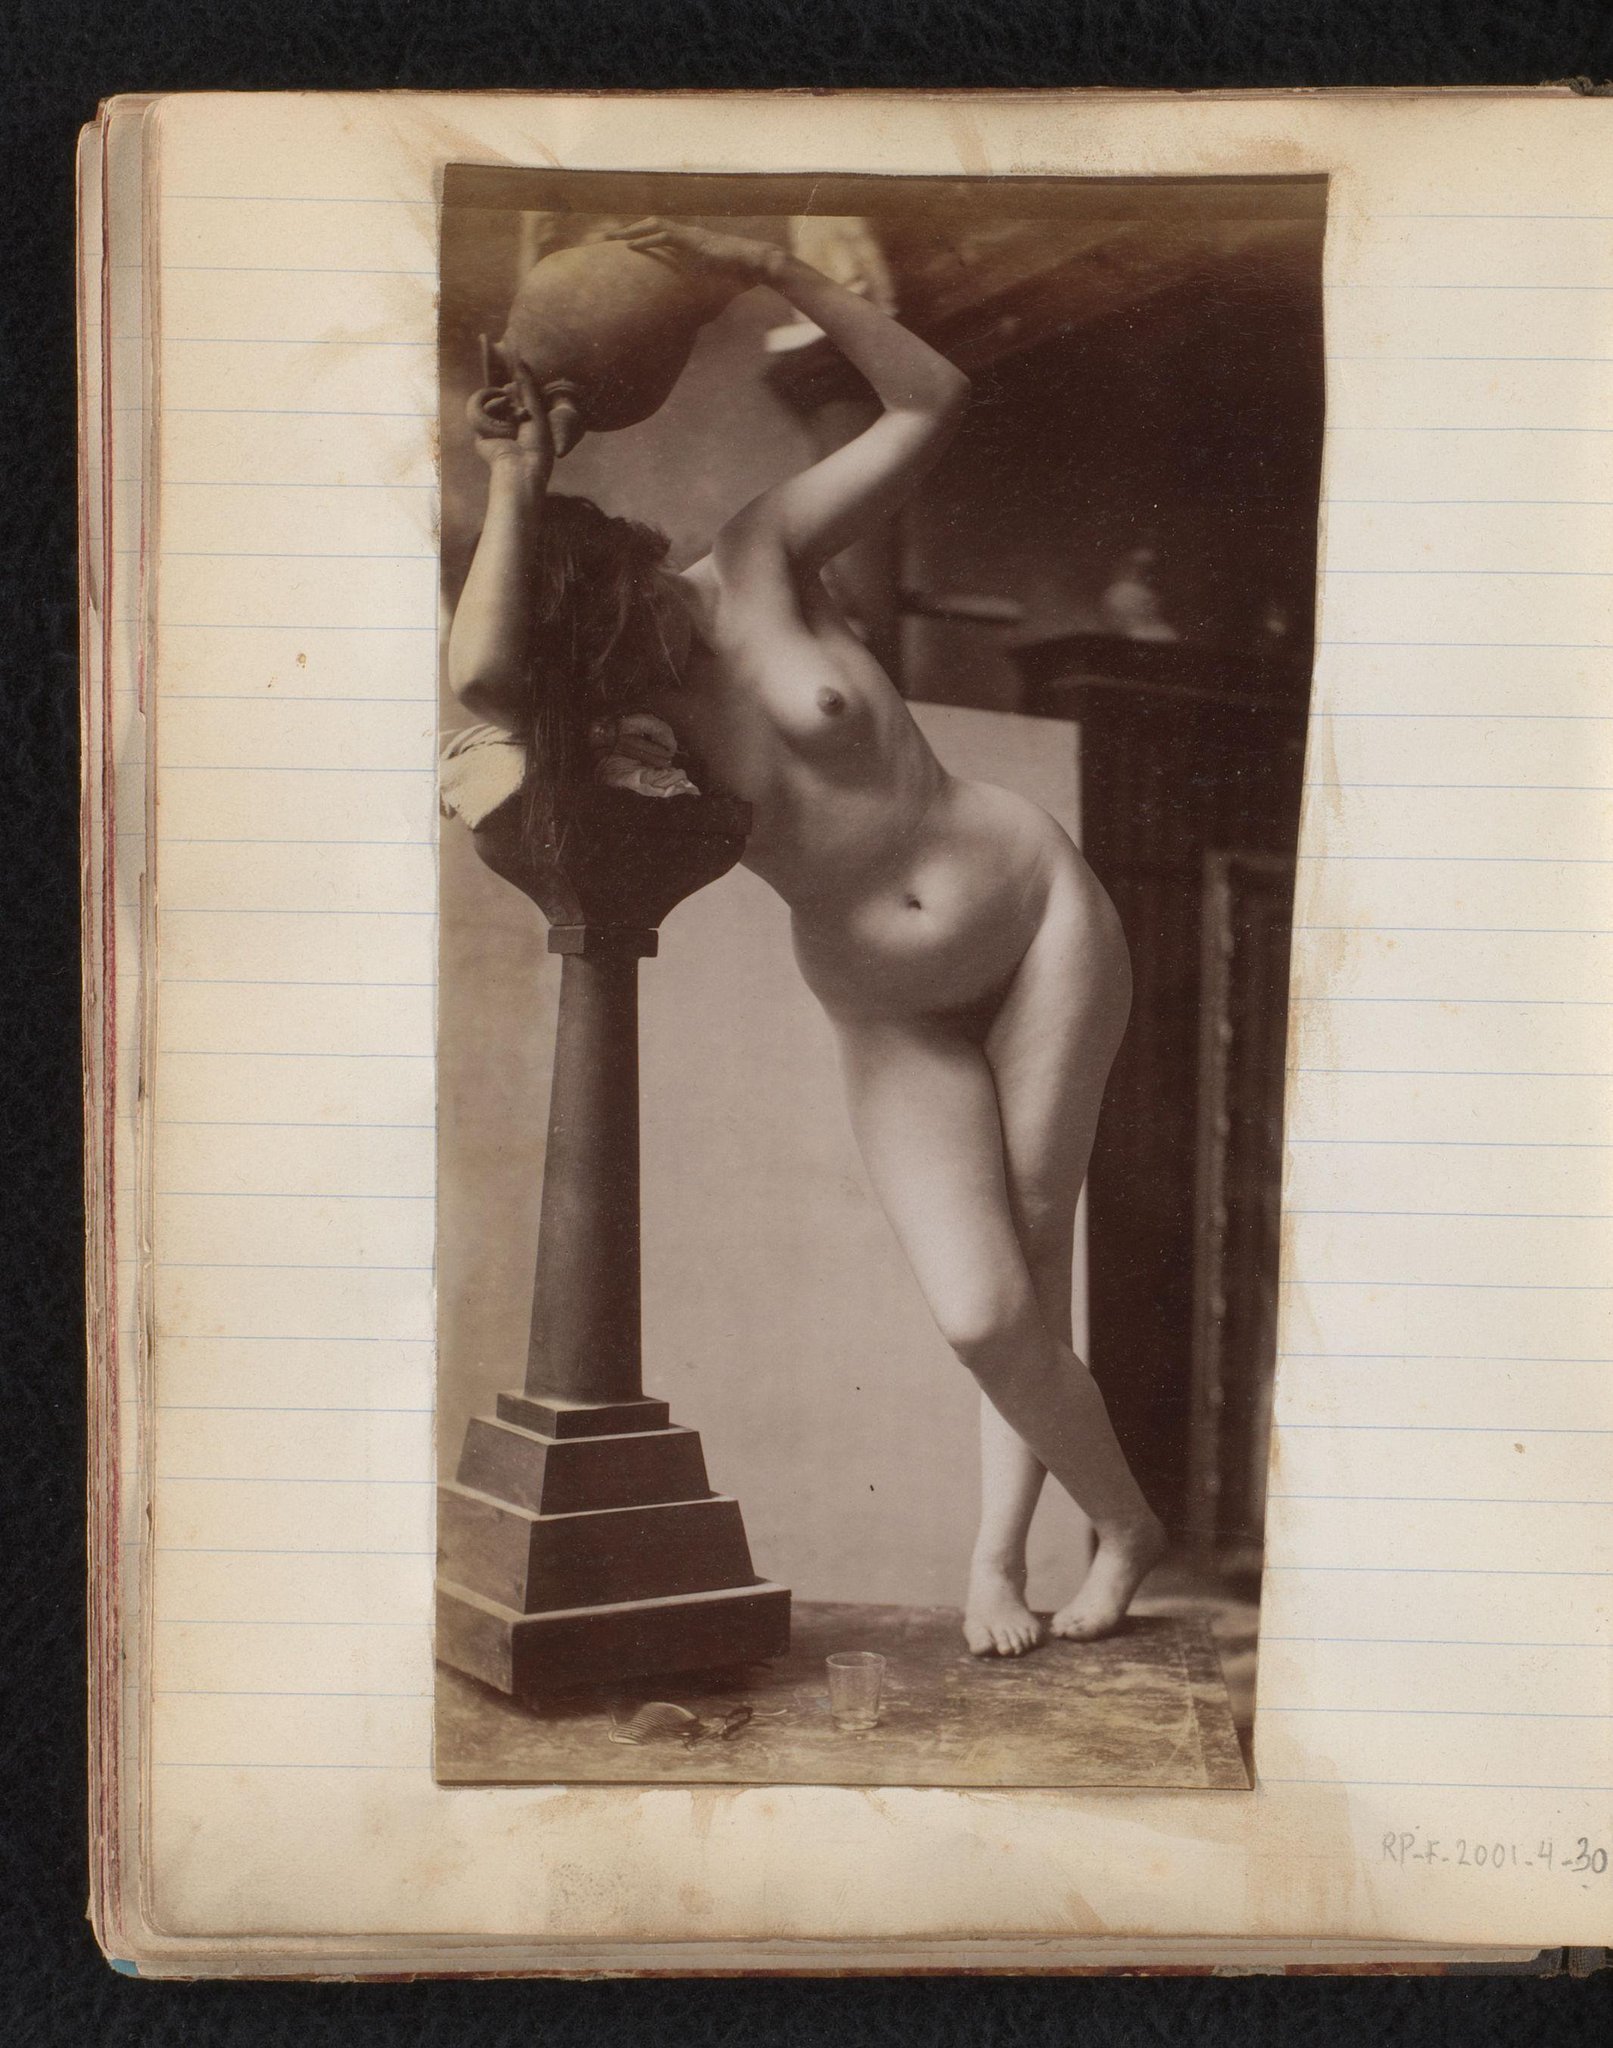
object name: album leaf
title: Studie van een vrouwelijk naaktmodel, recht van voren gezien, in het atelier van Jacques de Lalaing, voorstudie voor cirkelvormige fontein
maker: jacques lalaing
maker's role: painter, sculptor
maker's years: 1858-1917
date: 1903-1914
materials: photographic support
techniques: albumen print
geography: brussels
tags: adult woman, the (nude) human figure; 'corpo humano' (ripa) (+ front view), artist (in general) working from nude model